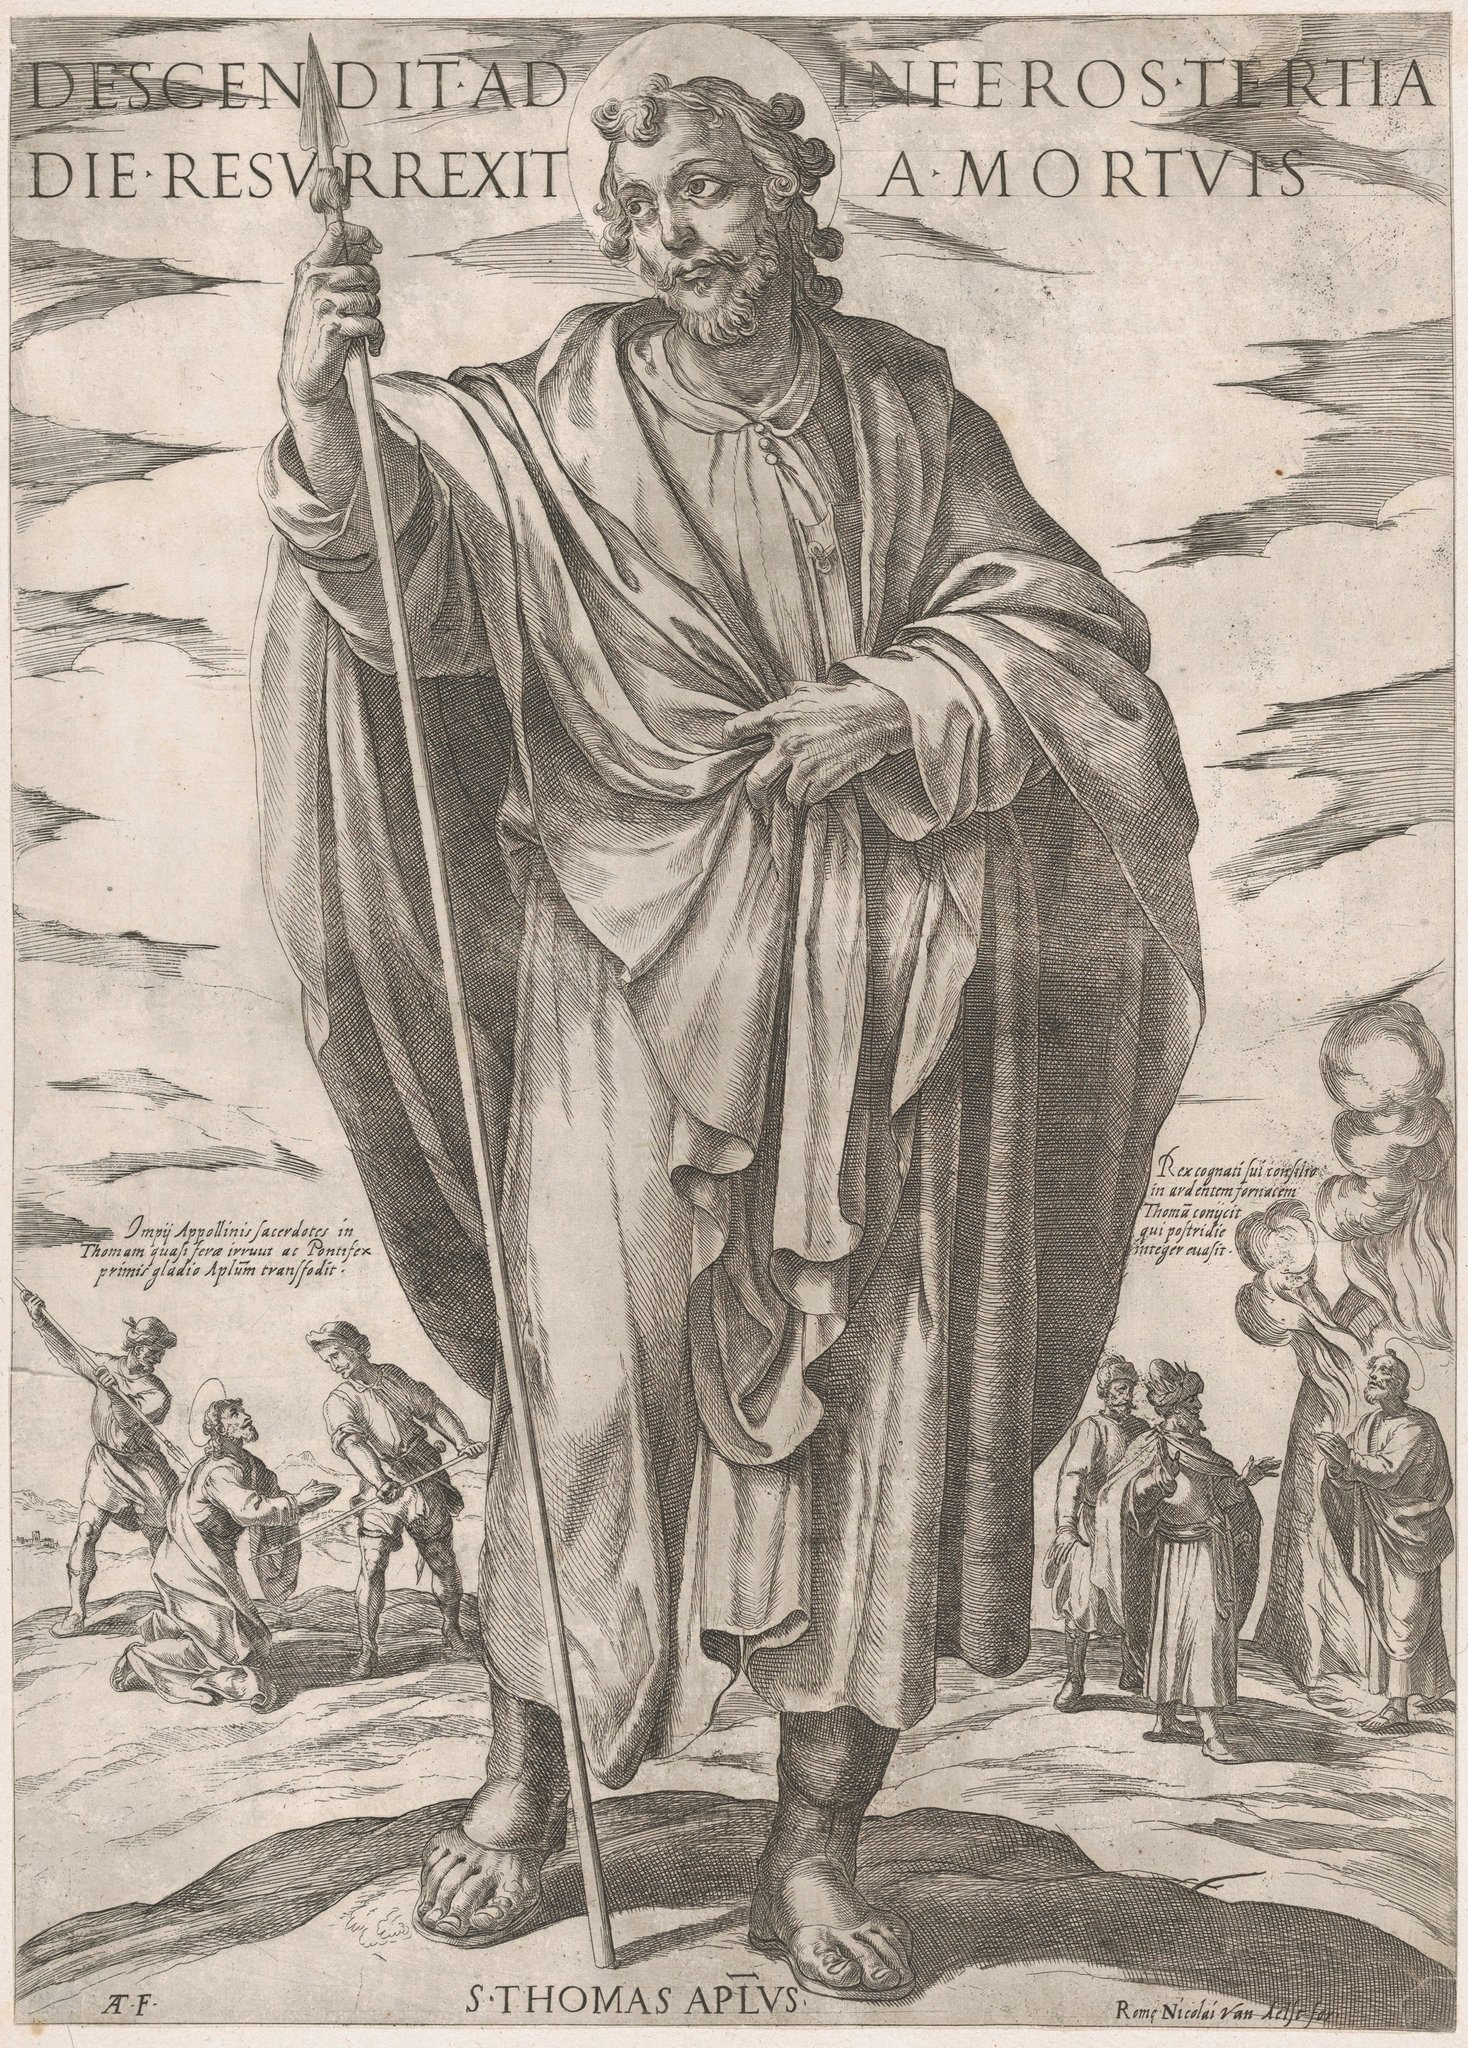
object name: print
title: St. Thomas, from "Christ, Mary and the Apostles"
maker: antonio tempesta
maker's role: artist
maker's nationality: italian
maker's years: 1555-1630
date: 1567-1600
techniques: etching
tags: spears,saints